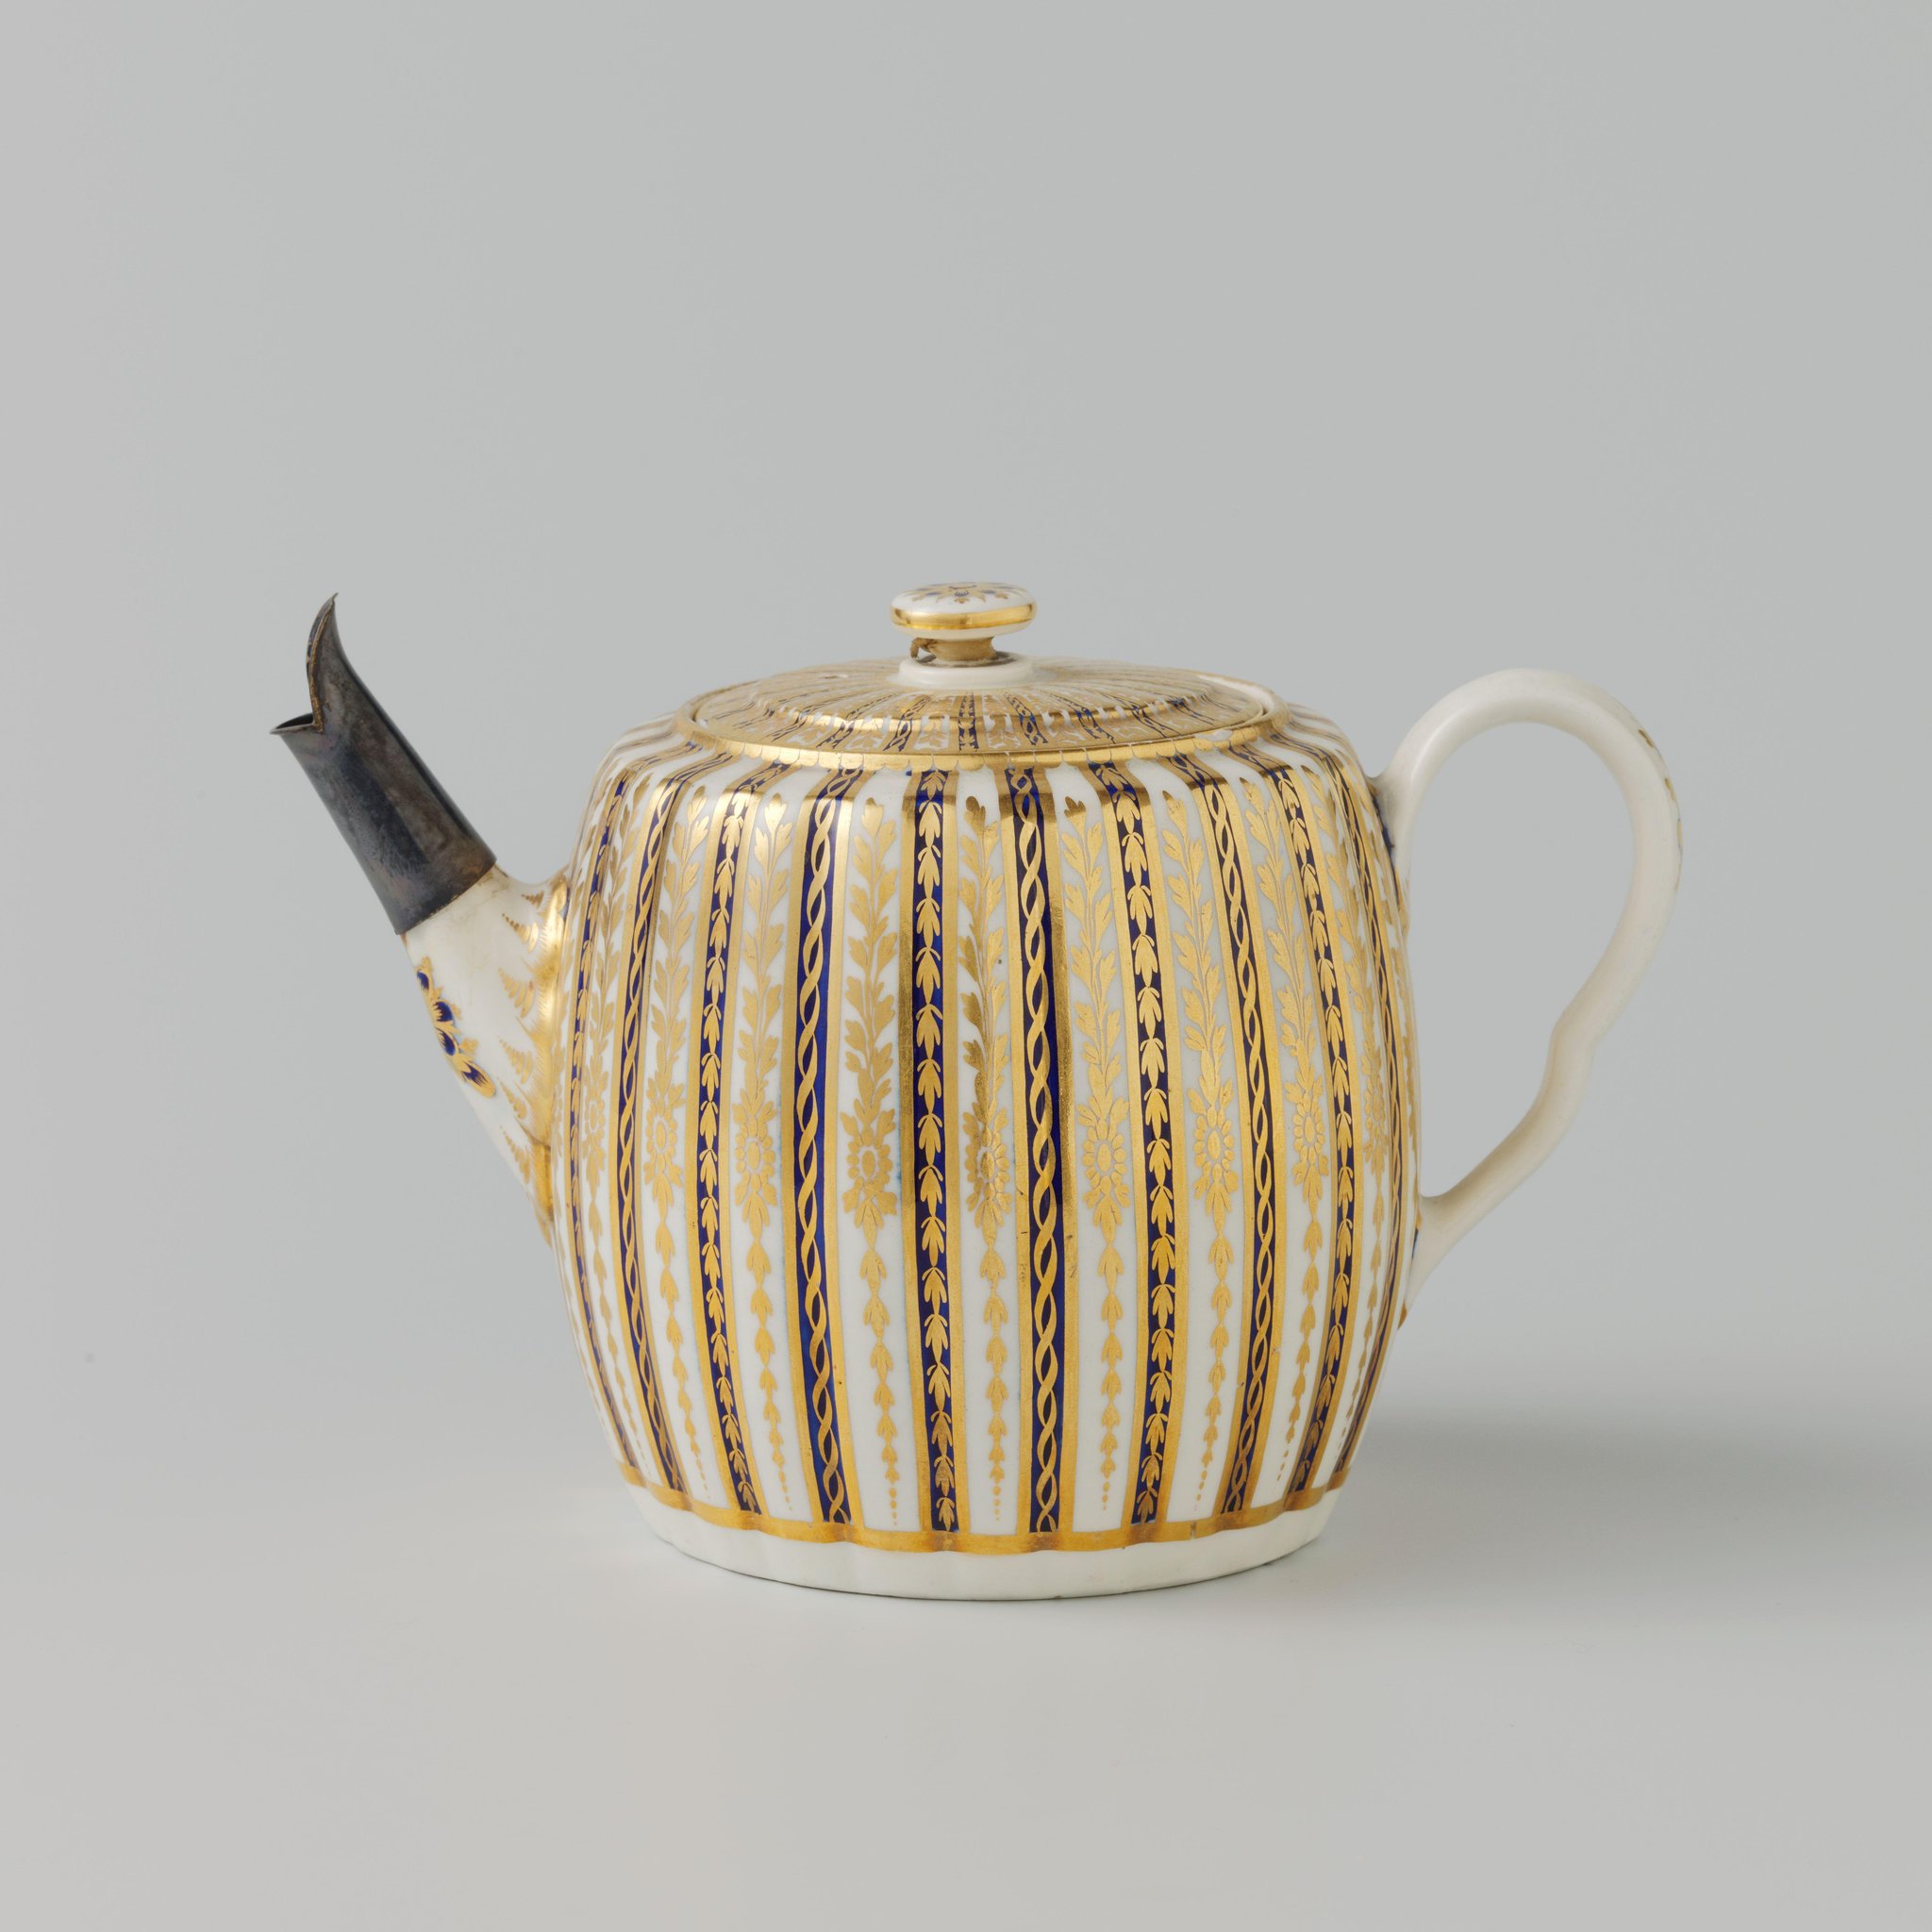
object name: lid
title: Deksel van een theepot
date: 1775-1800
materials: earthenware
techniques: vitrification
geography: worcester